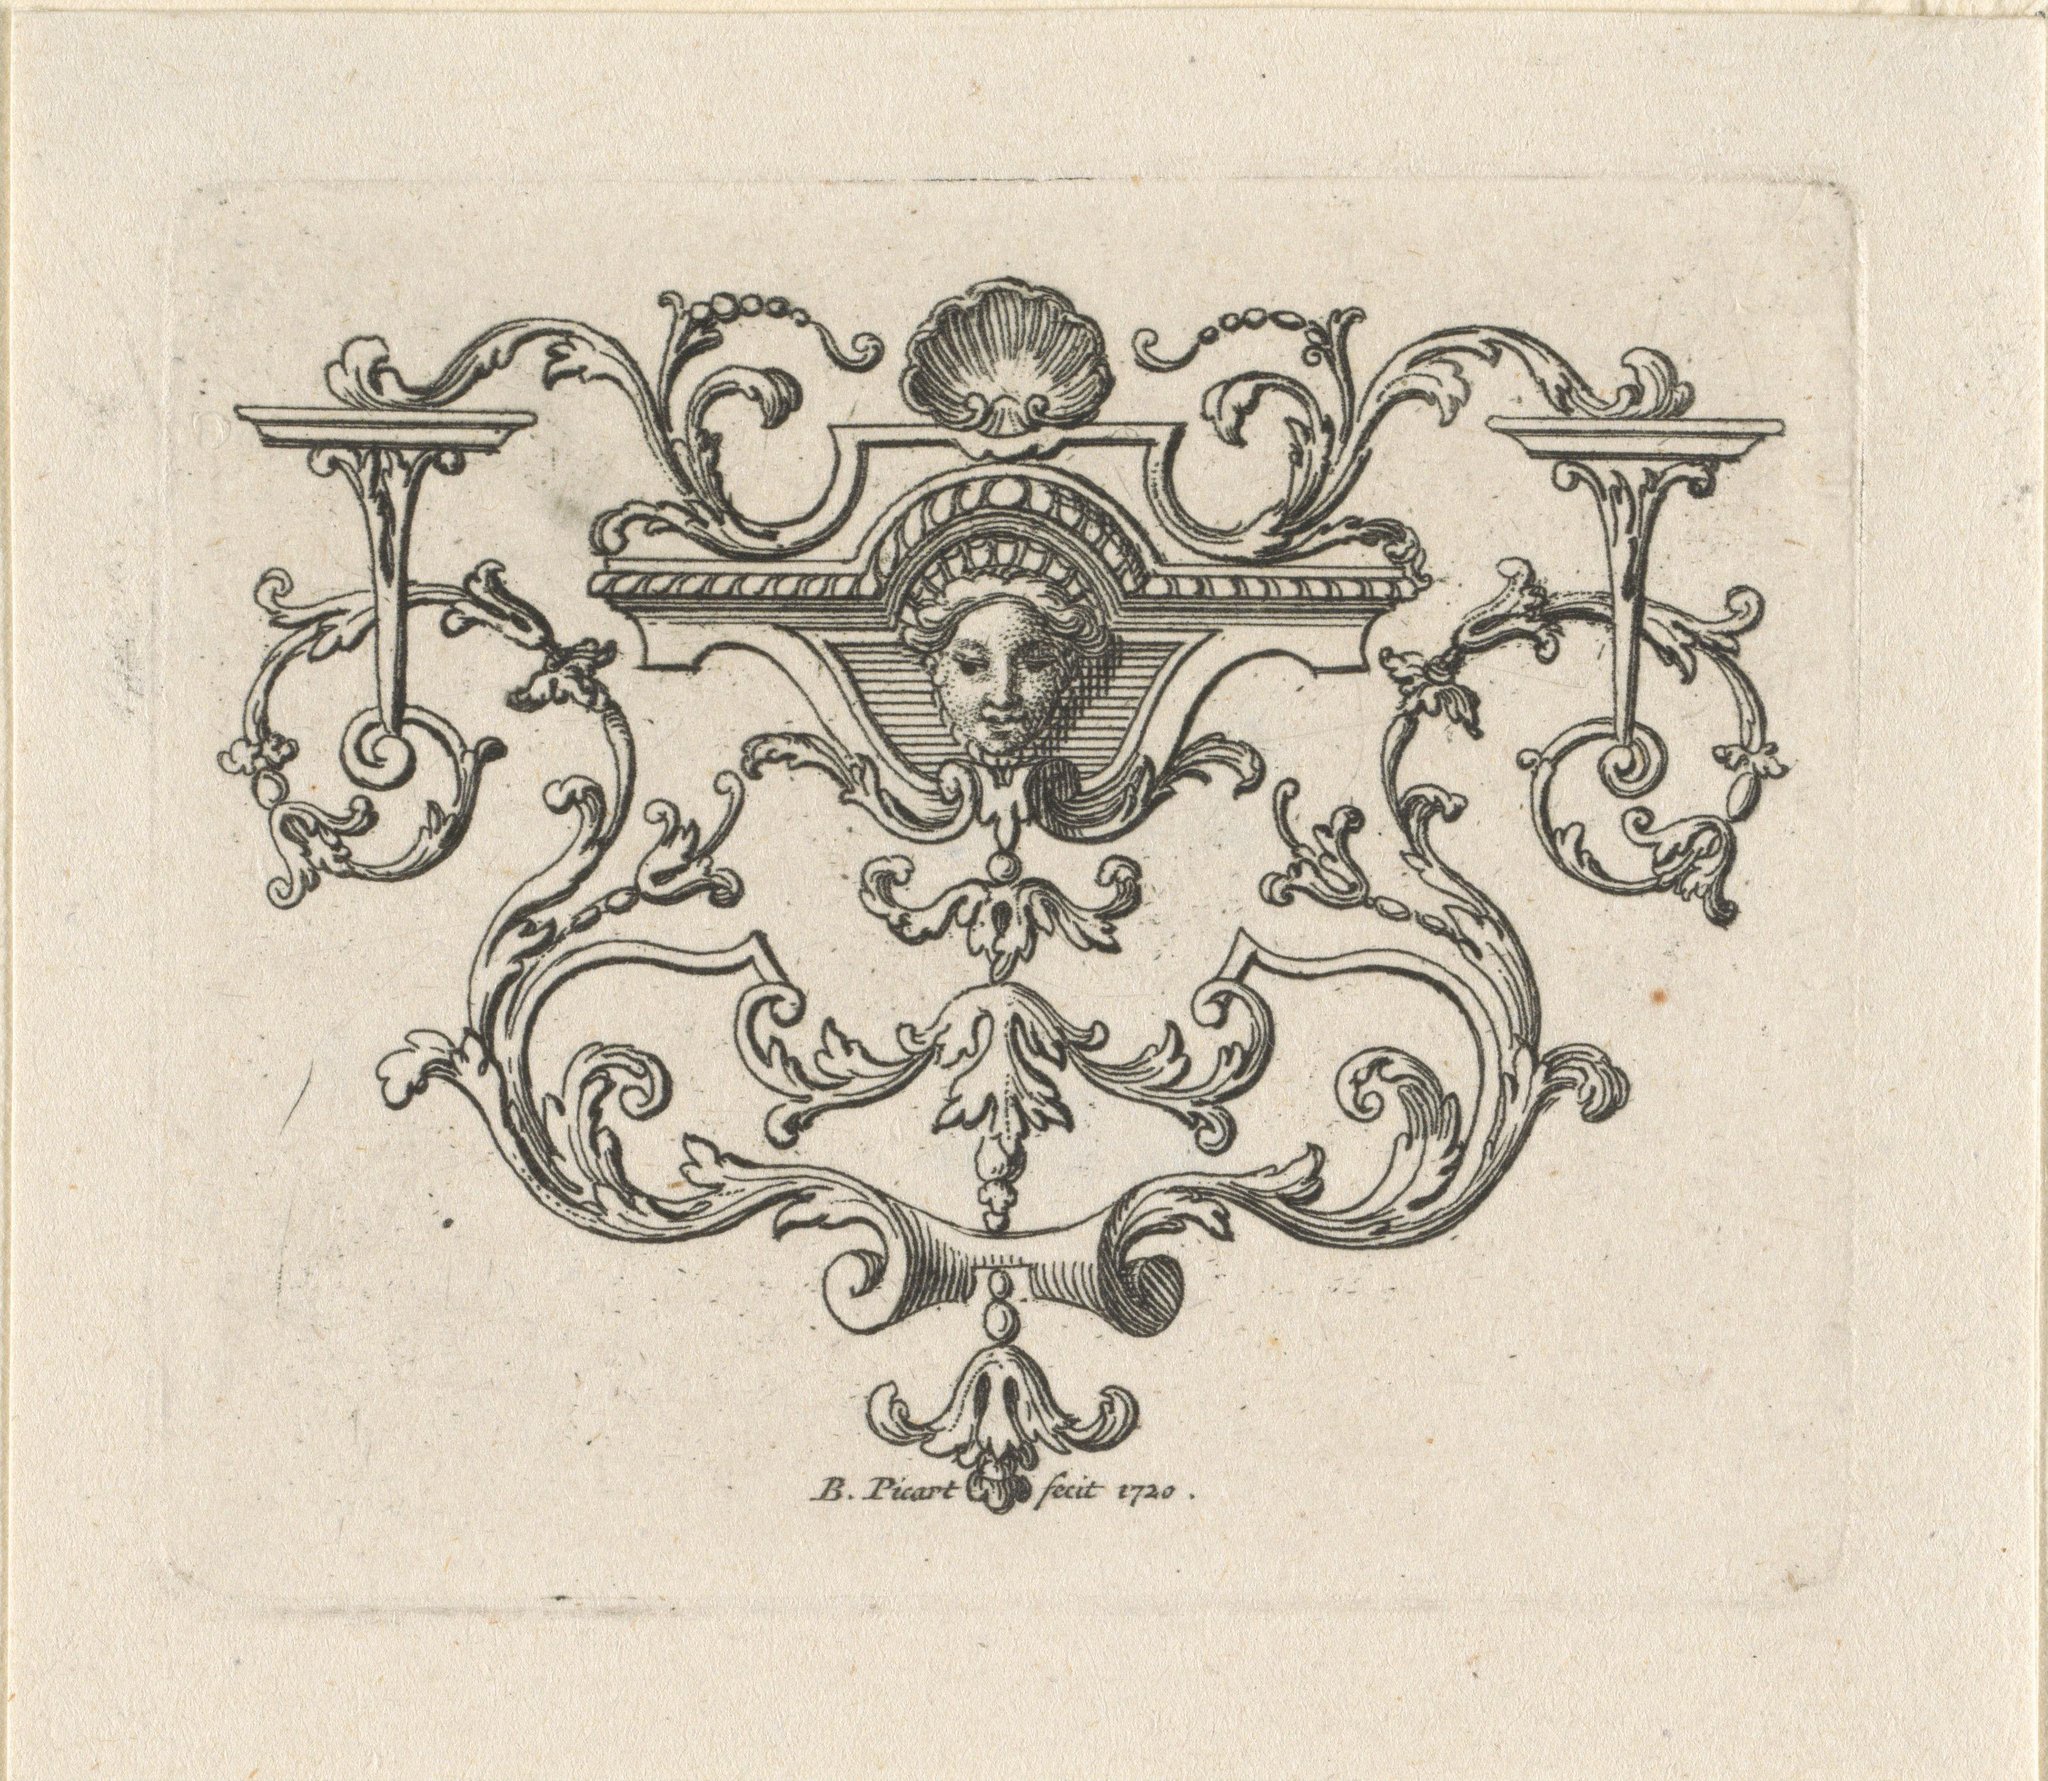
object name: ornament print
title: Ornament met vrouwgezicht en schelp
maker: bernard picart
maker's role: draughtsman, print maker, publisher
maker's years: 1673-1733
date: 1720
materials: paper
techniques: engraving, etching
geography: amsterdam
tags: mask, mascaron ~ ornament, foliage, tendrils, branches ~ ornament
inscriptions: collector's mark: Lugt 2233